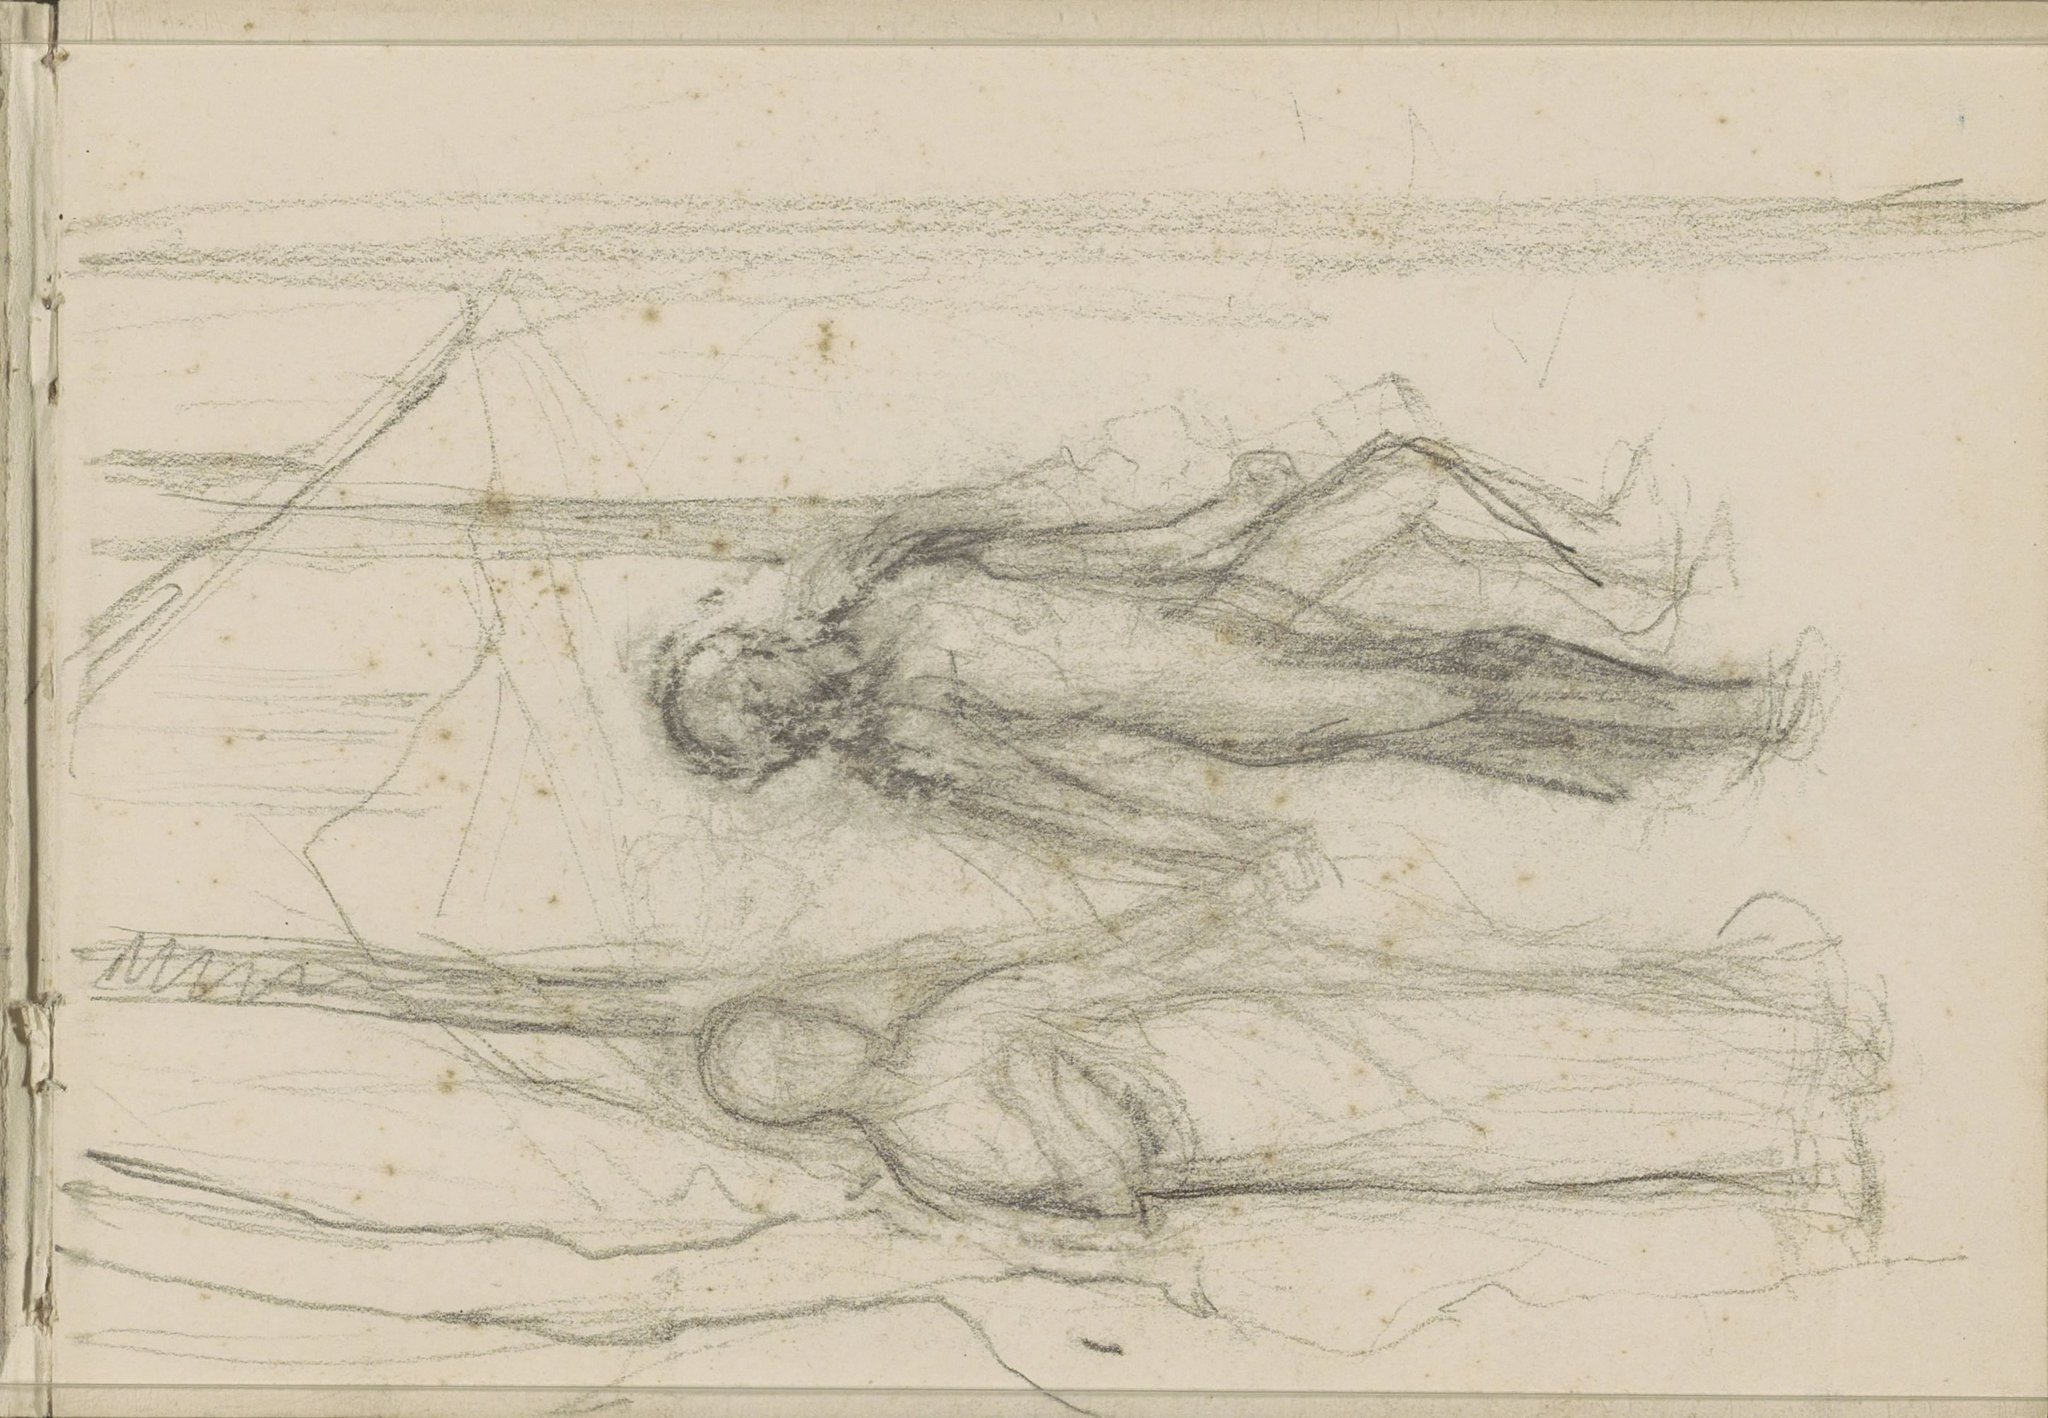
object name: sketchbook leaf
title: Bos met een man en vrouw die hand in hand lopen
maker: a.a.l. de grammont-hubrecht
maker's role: draughtsman, painter, print maker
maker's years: 1855-1913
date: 1865-1913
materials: chalk, paper, pencil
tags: adult woman, postures and gestures of arm(s) and hand(s) in relation to another person, adult man, forest, wood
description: Blad 2 recto uit een schetsboek met 68 bladen.